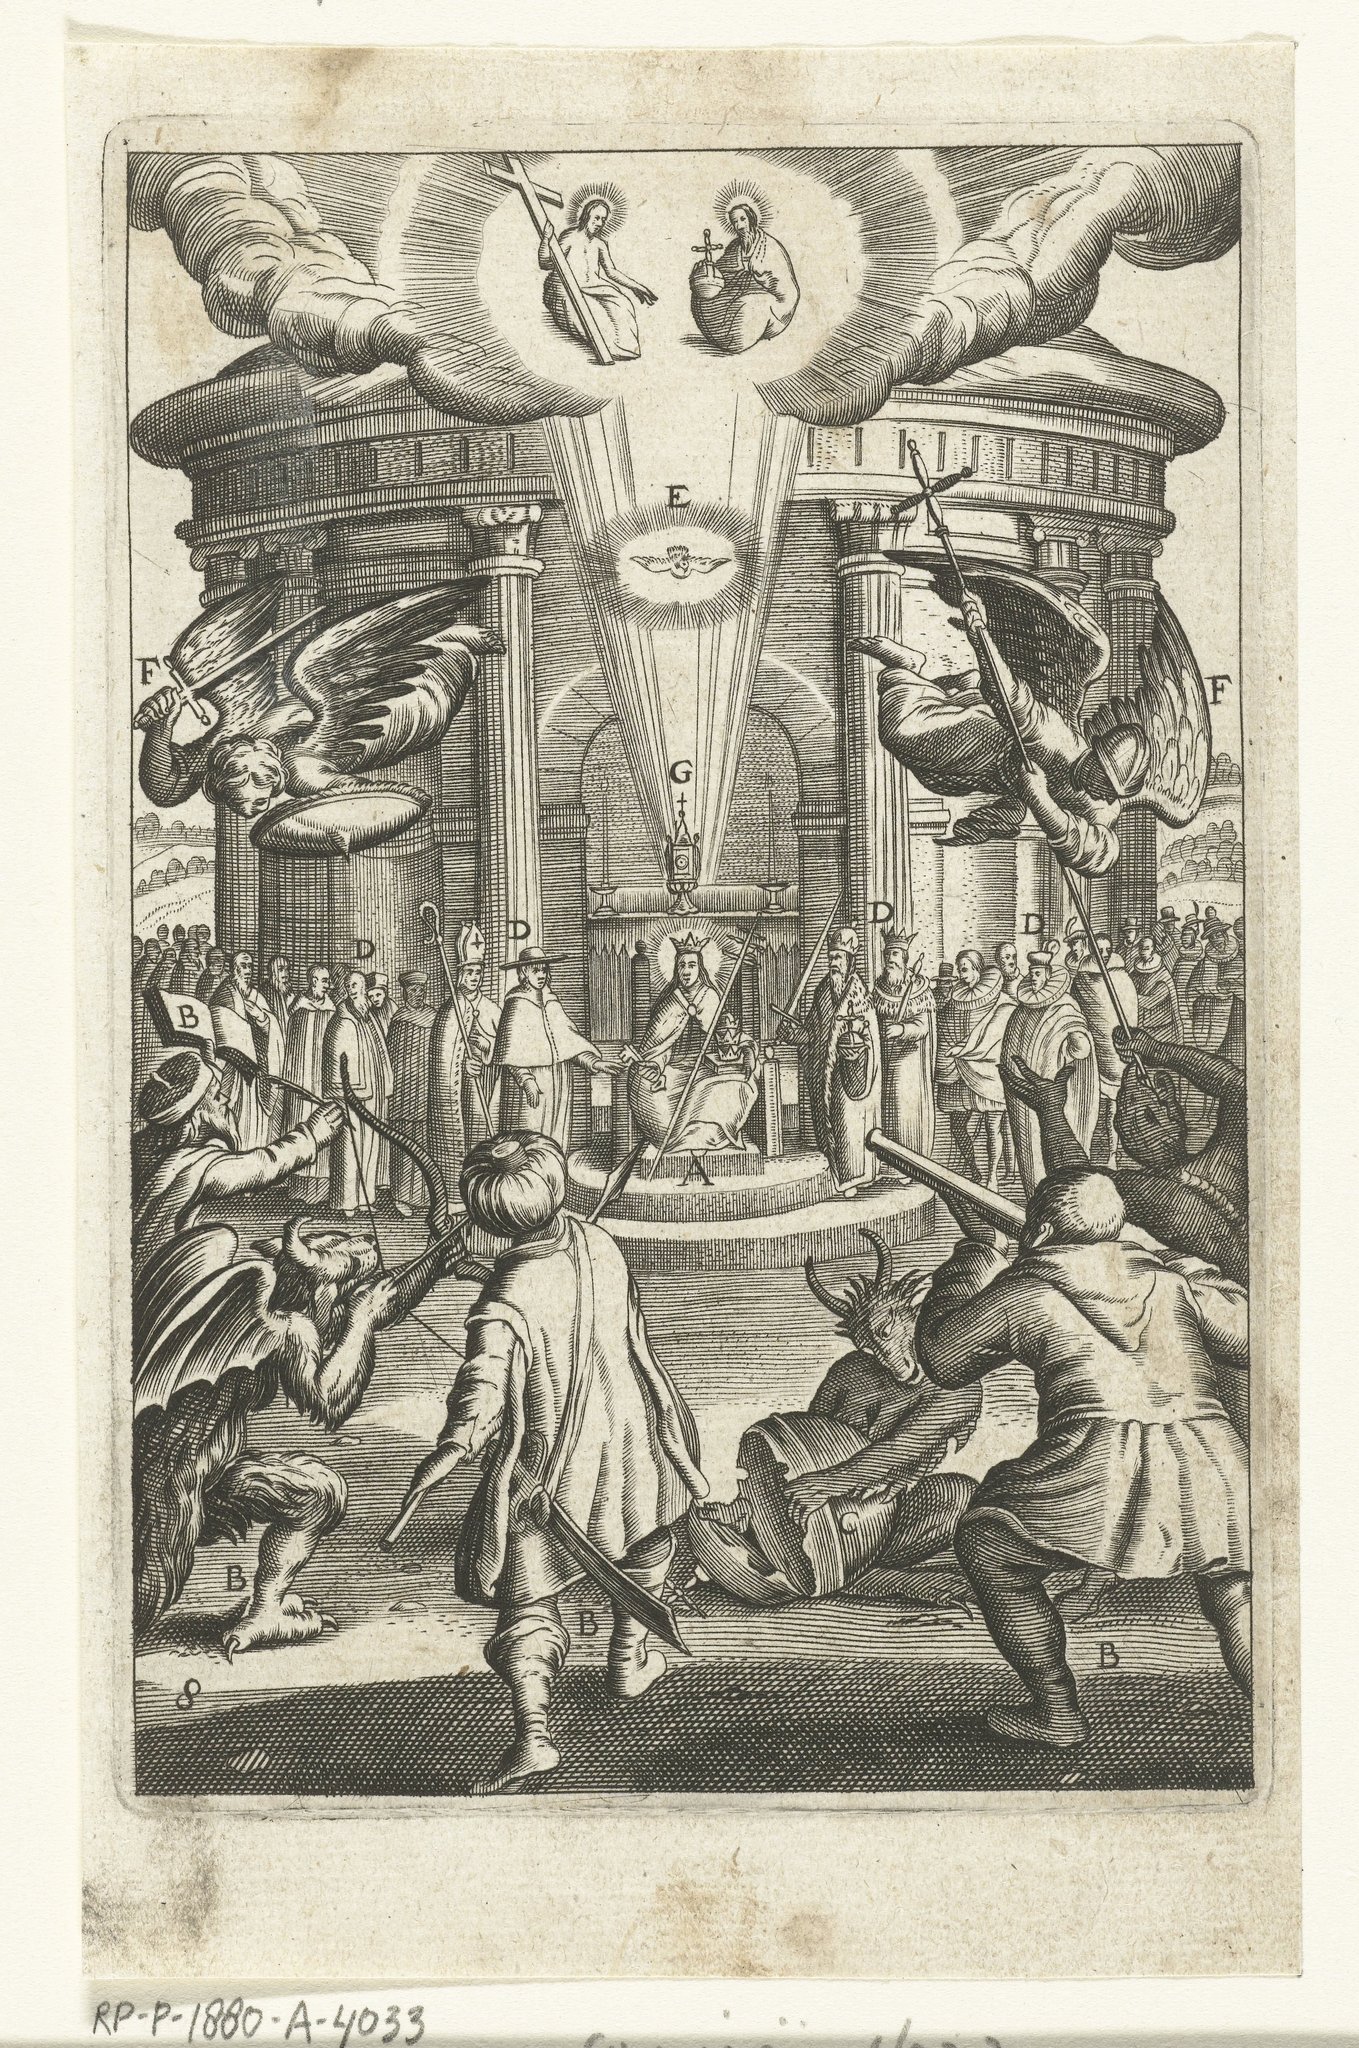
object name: print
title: Den wech des eeuwich levens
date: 1620-1623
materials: paper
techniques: engraving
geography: antwerp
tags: the life of man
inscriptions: collector's mark: Lugt 2228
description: Voor een rond kerkgebouw zijn personen weergegeven die de kerk representeren zoals Christus en geestelijken. Twee engelen nemen de kerk tegen aanvallen van ongelovigen of goddelozen in bescherming. Een duivel breekt de globe. De tekst bij deze illustratie in het boek spoort de lezer aan om zich te ontfermen over de kerk en haar te beschermen met godvruchtigheid.